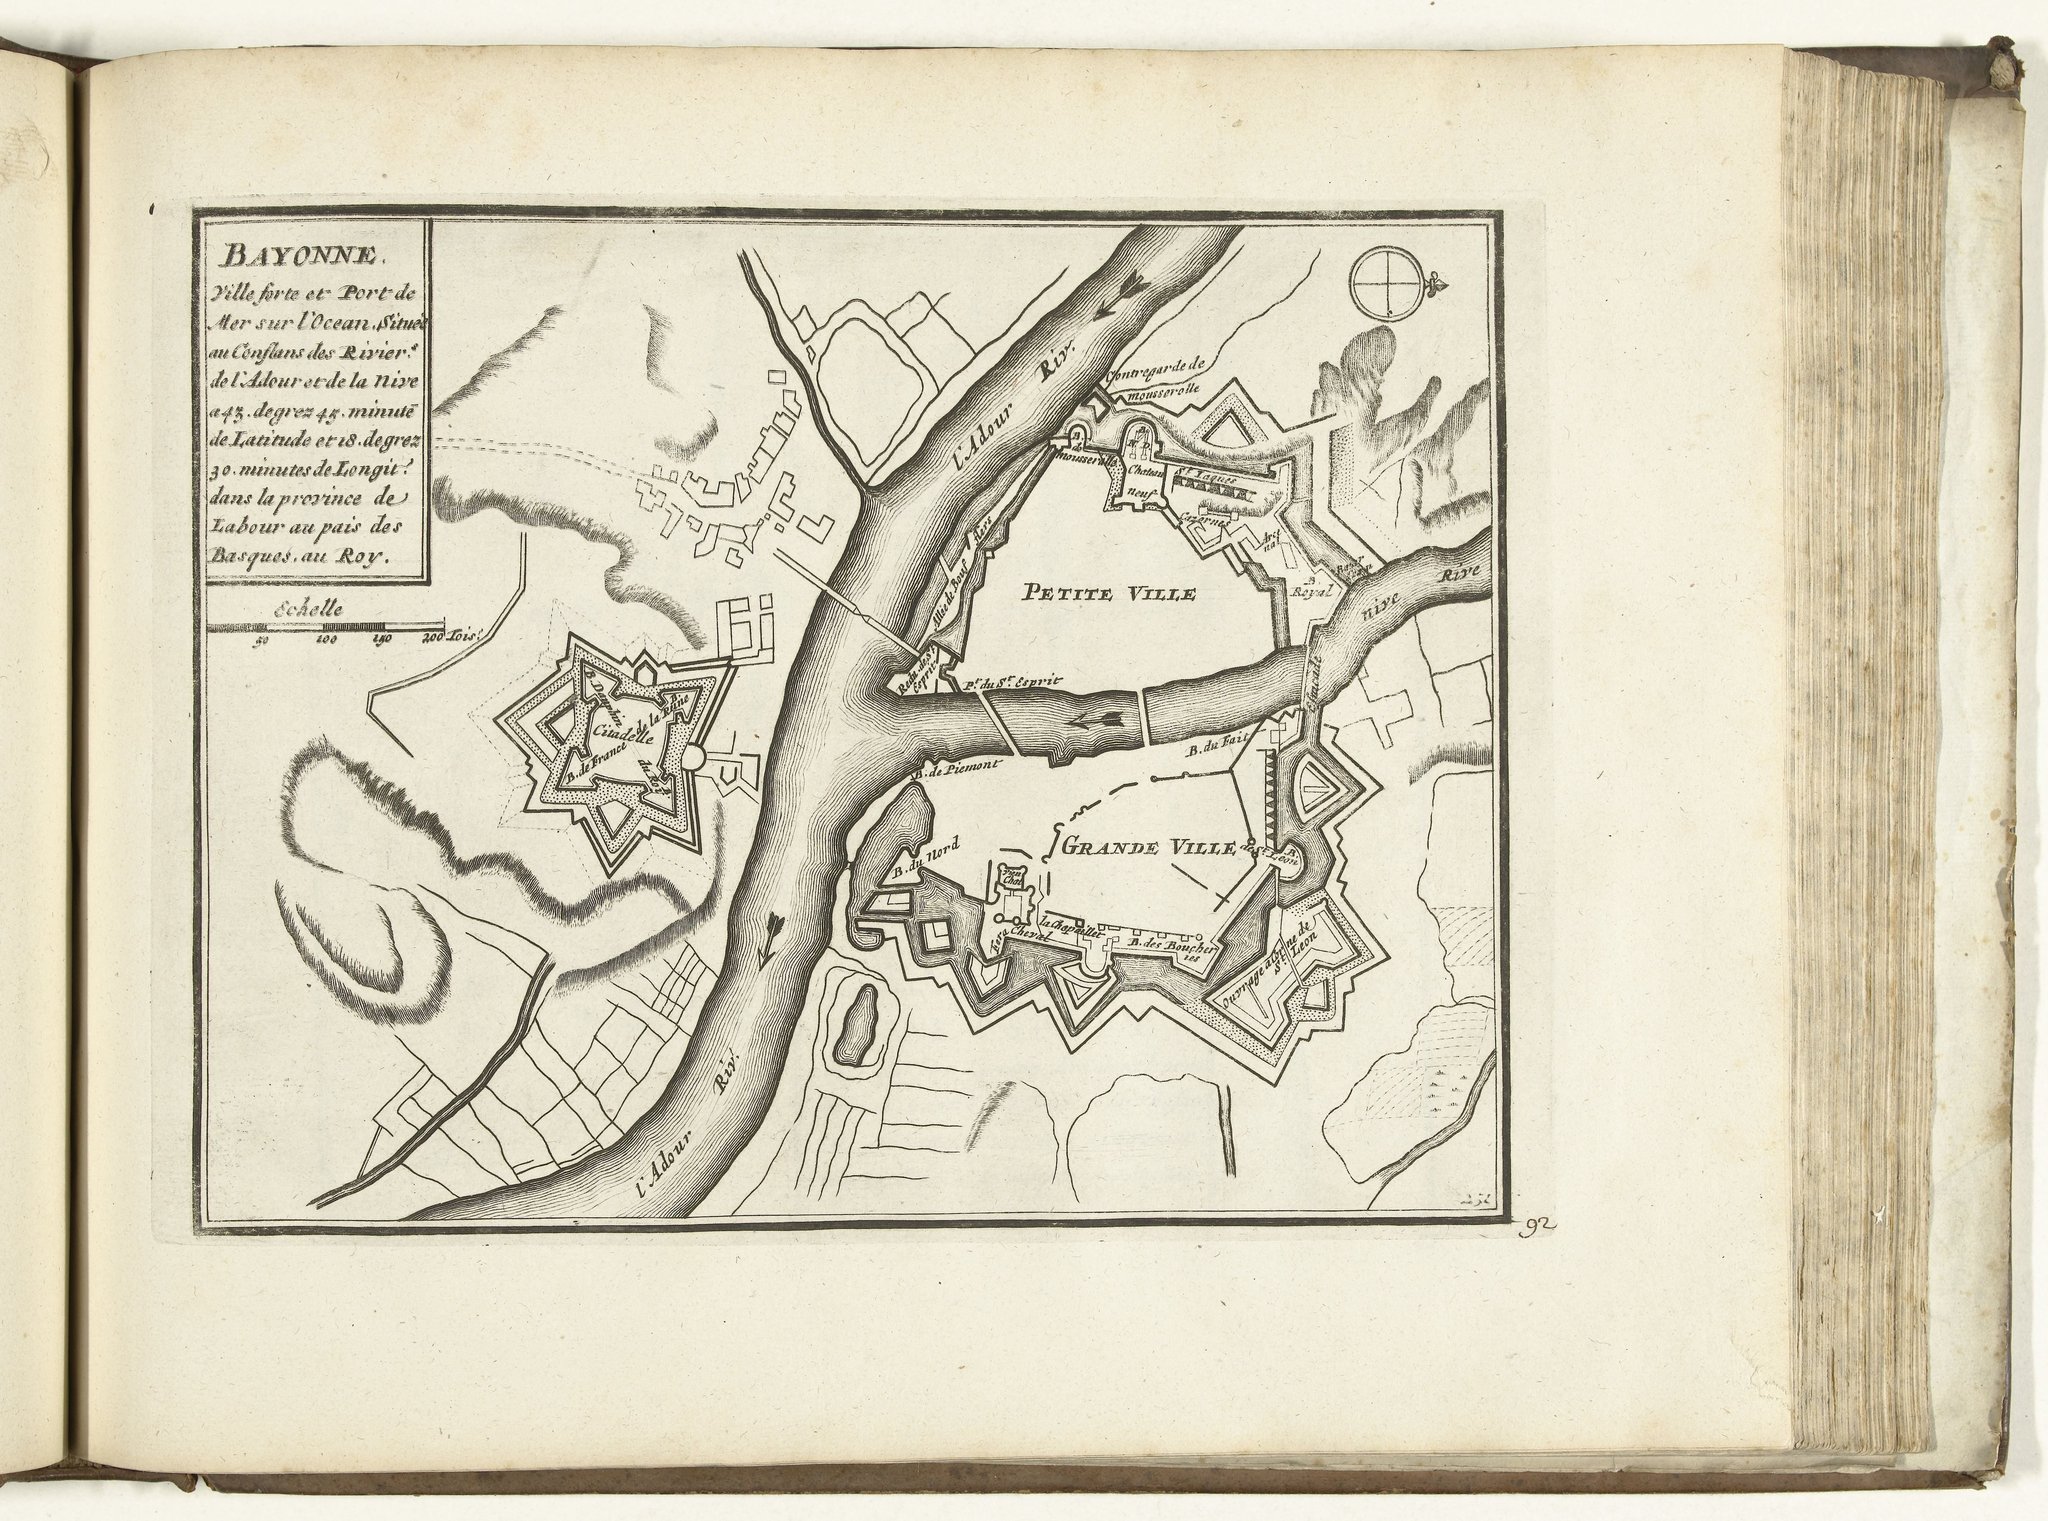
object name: print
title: Bayonne. Ville forte et Port de Mer (...)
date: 1726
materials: paper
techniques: engraving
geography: northern netherlands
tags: fortress, maps of cities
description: Plattegrond van de versterkingen om de Franse stad Bayonne. Plaat nr. 92 in deel IV van het prentwerk: Les Forces de l'Europe, Asie, Afrique et Amerique ... Comme aussi les Cartes des Côtes de France et d'Espagne uit 1726, dit eerste deel met 238 met de hand genummerde platen van vermaarde sterke steden en vestingen in het kader van de Spaanse Successieoorlog 1701-1713. Voor het merendeel zijn deze platen gekopieerd naar de anonieme Franse platen van vermaarde sterke steden en vestingen: in Les forces de l'Europe en in: Le theatre de la guerre, dans les Pays-Bas, beide oorspronkelijk uitgegeven door Nicolas de Fer te Parijs (1693-1697) in het kader van de Negenjarige Oorlog. Titel en opschriften in het Frans. Rechtsonder sporen van het weggepolijste nummer: 251.